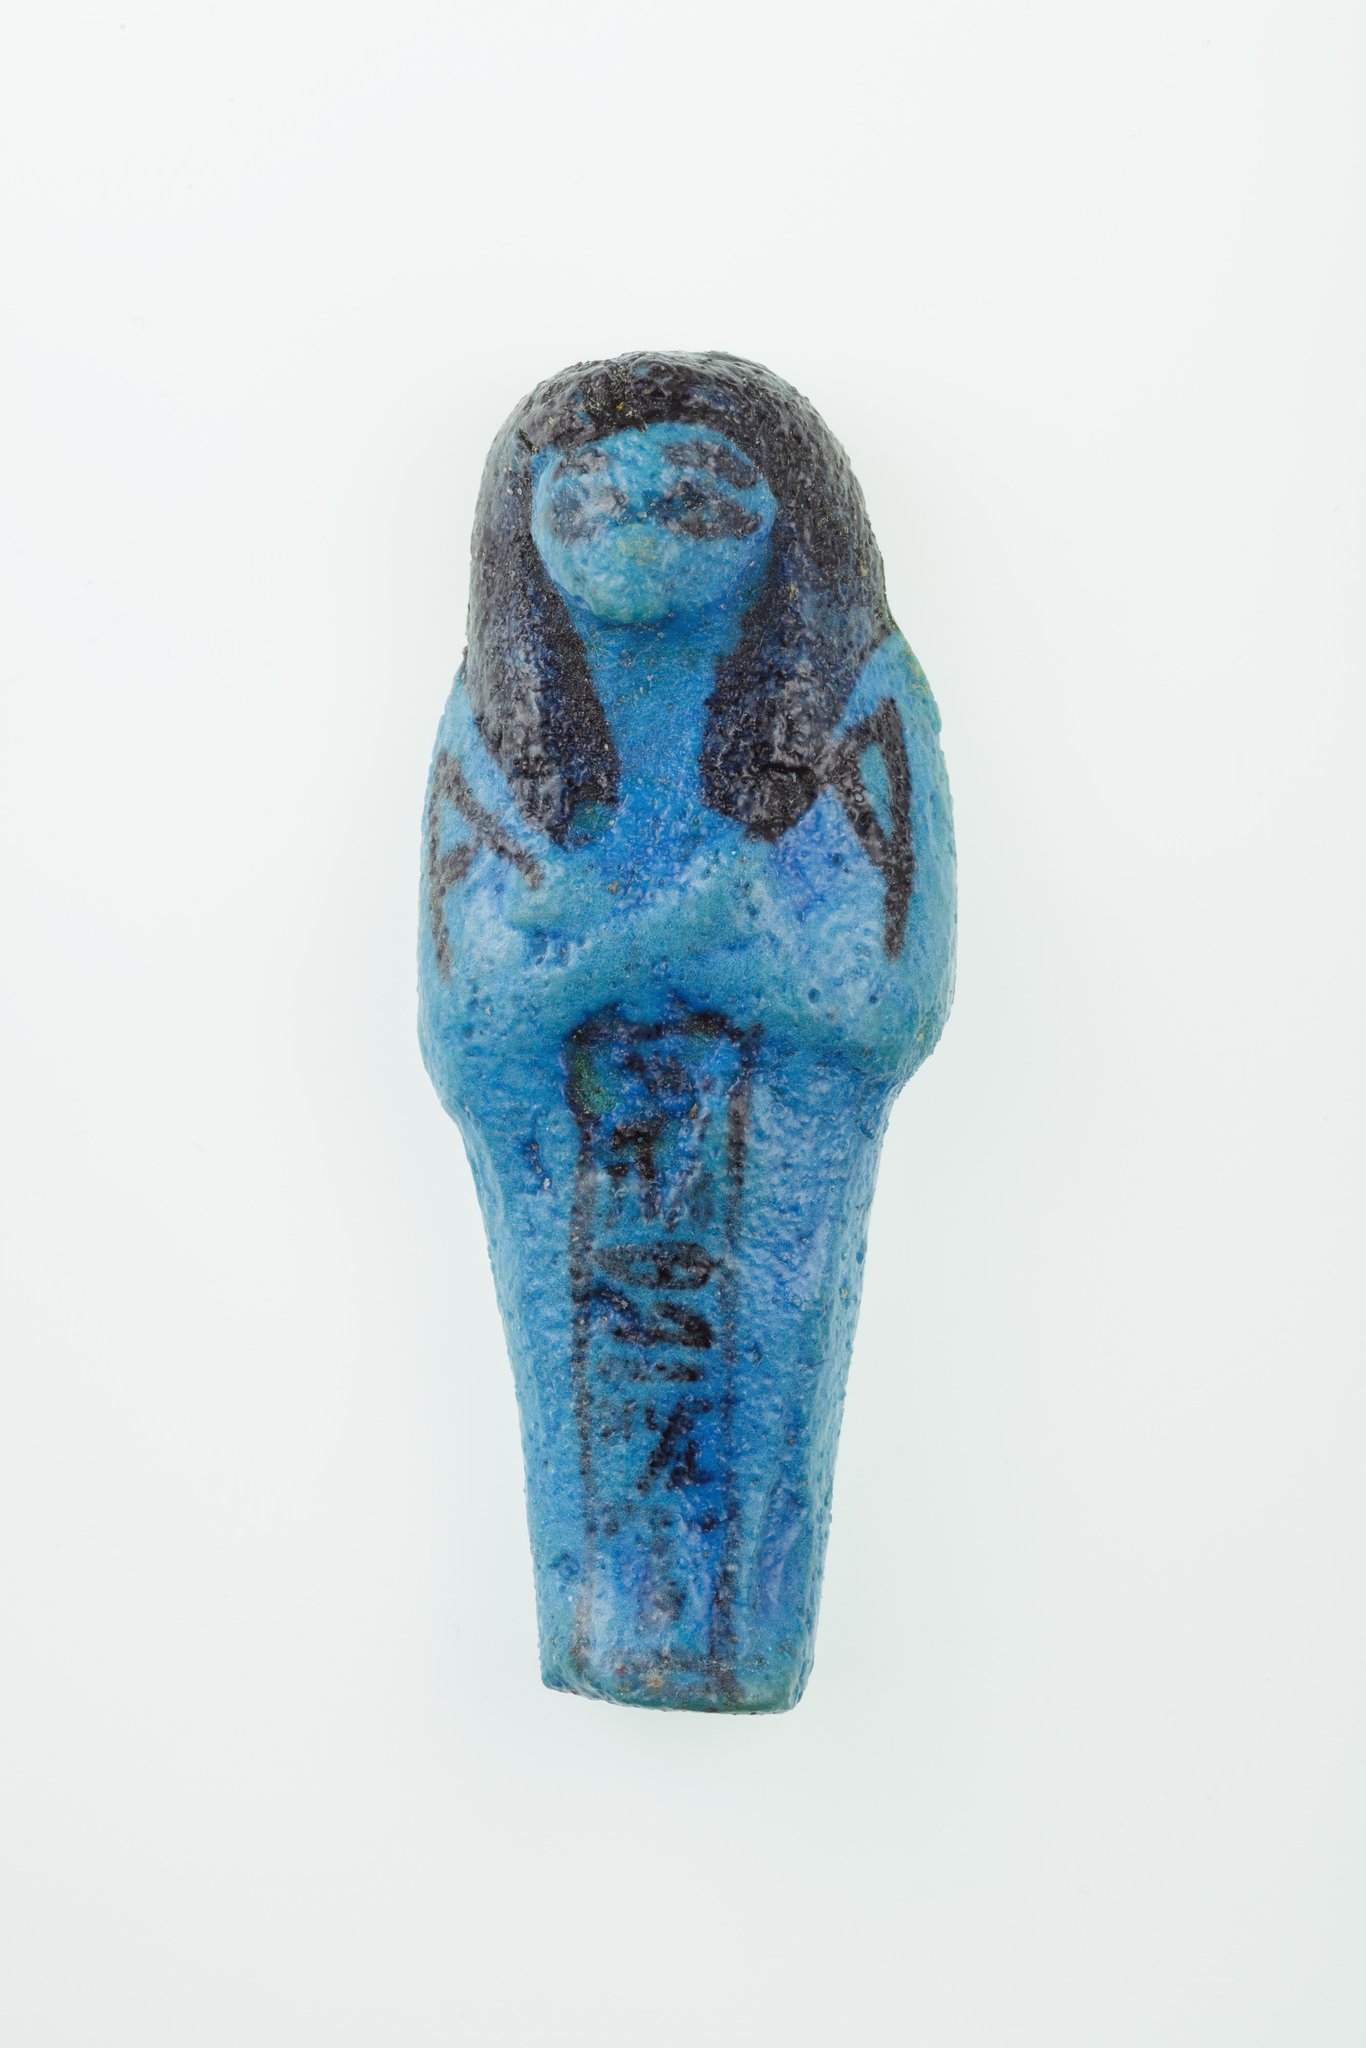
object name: shabti, worker, nauny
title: Worker Shabti of Nauny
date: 1050 BCE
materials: faience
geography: egypt